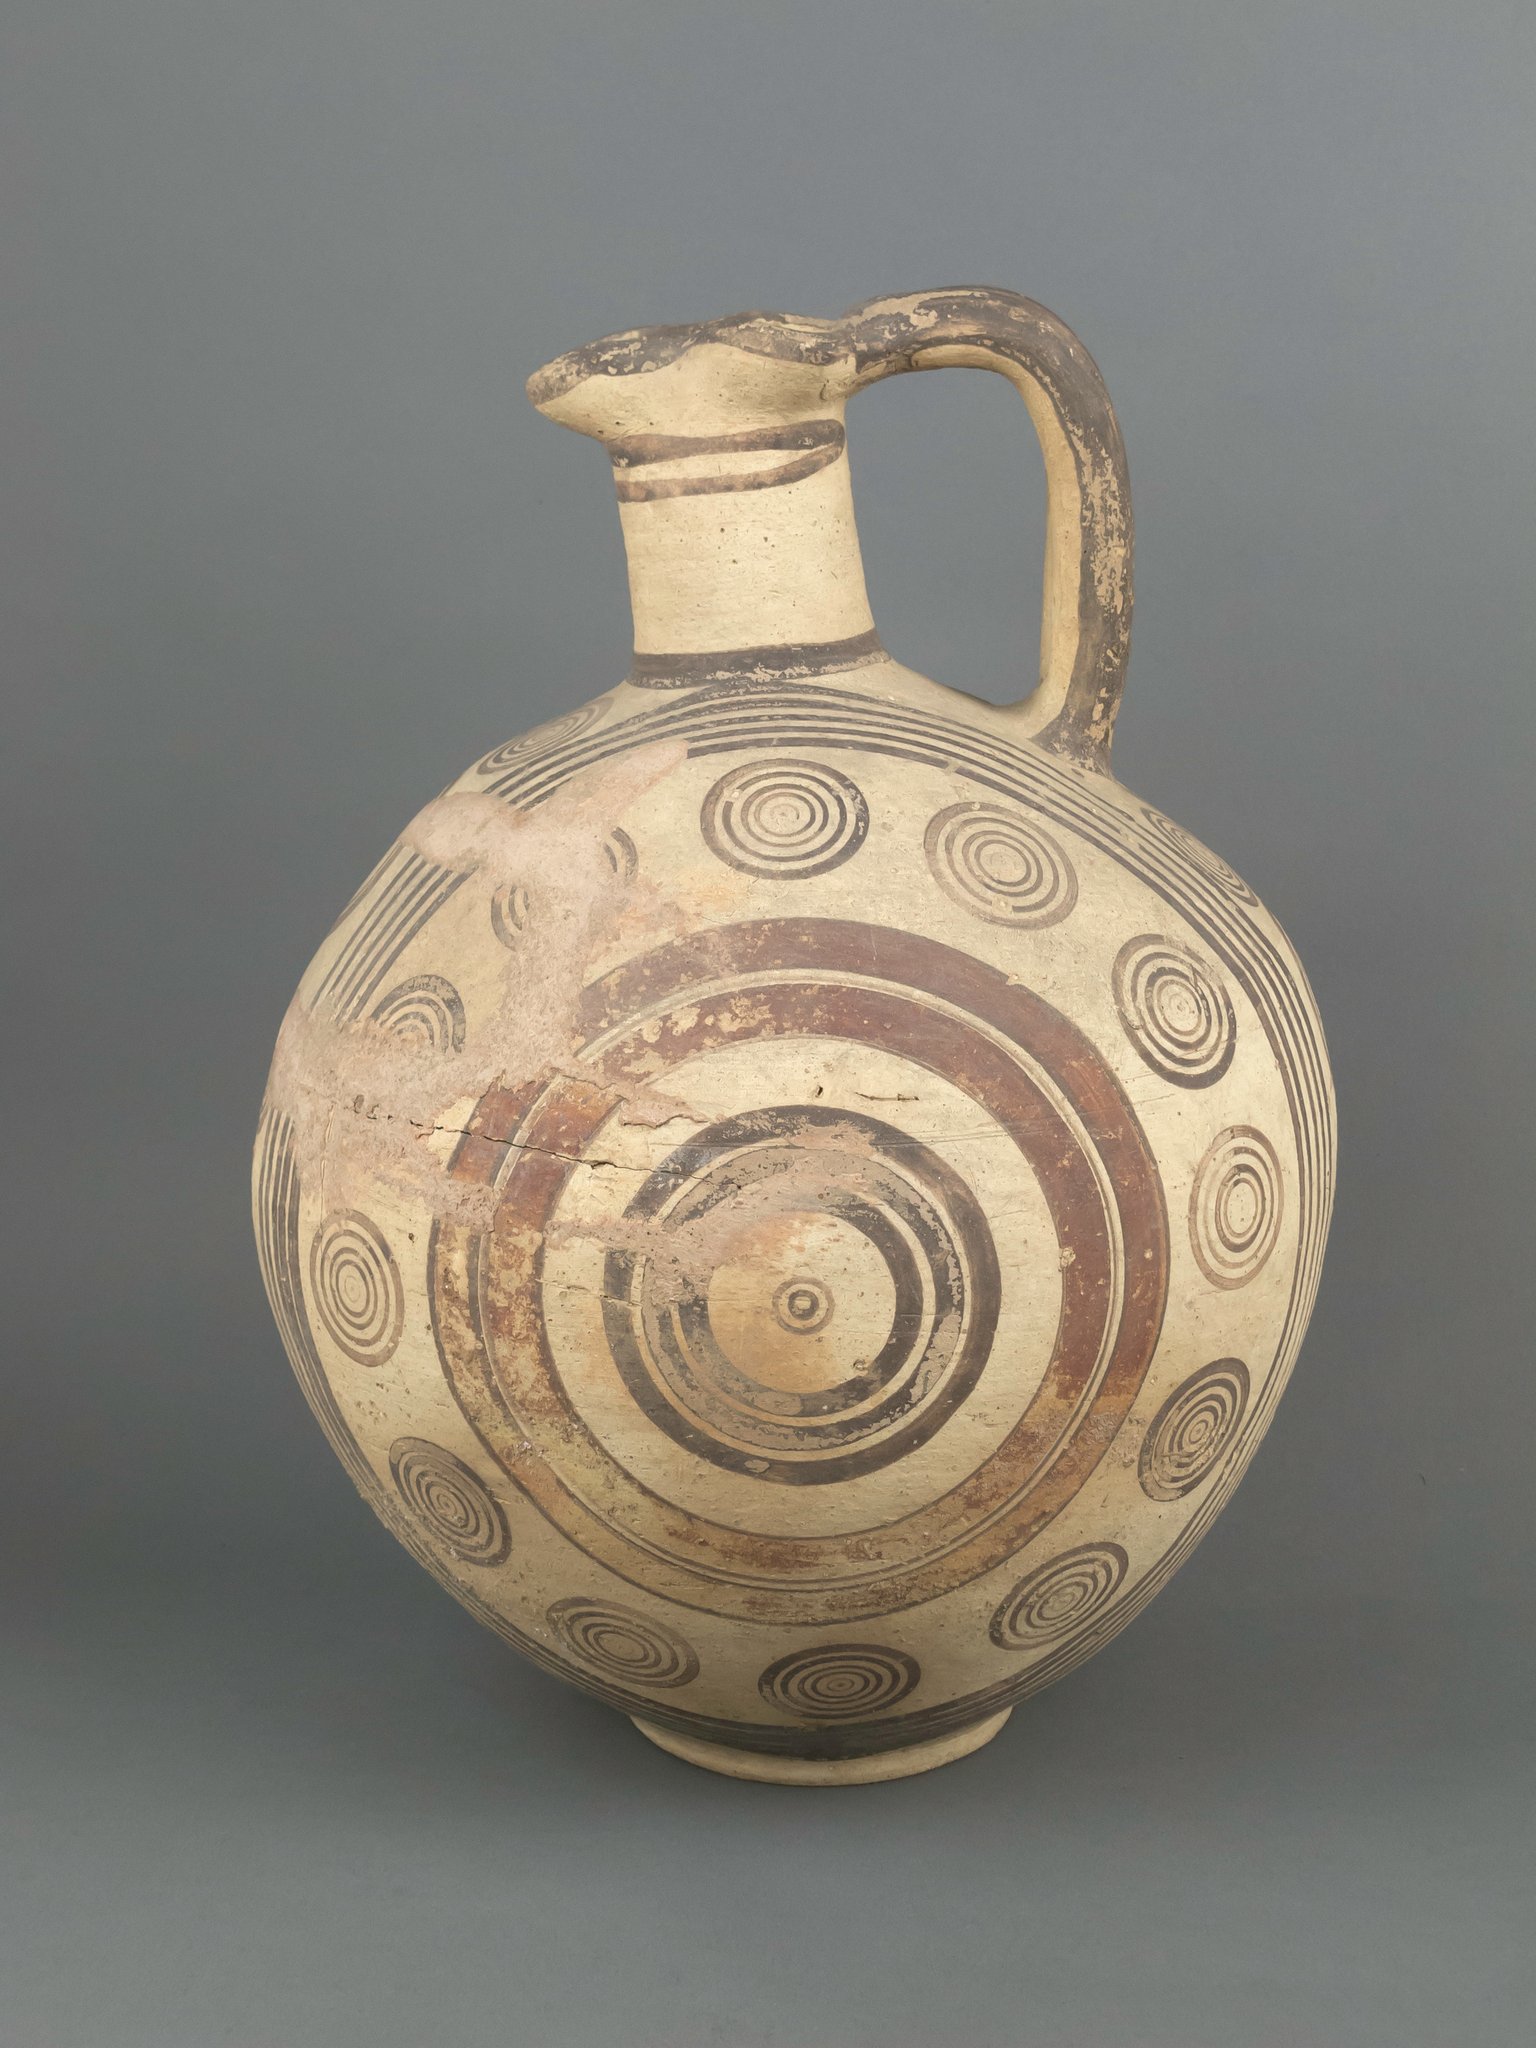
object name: oinochoe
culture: cypriot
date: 1125-1050 BCE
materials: terracotta